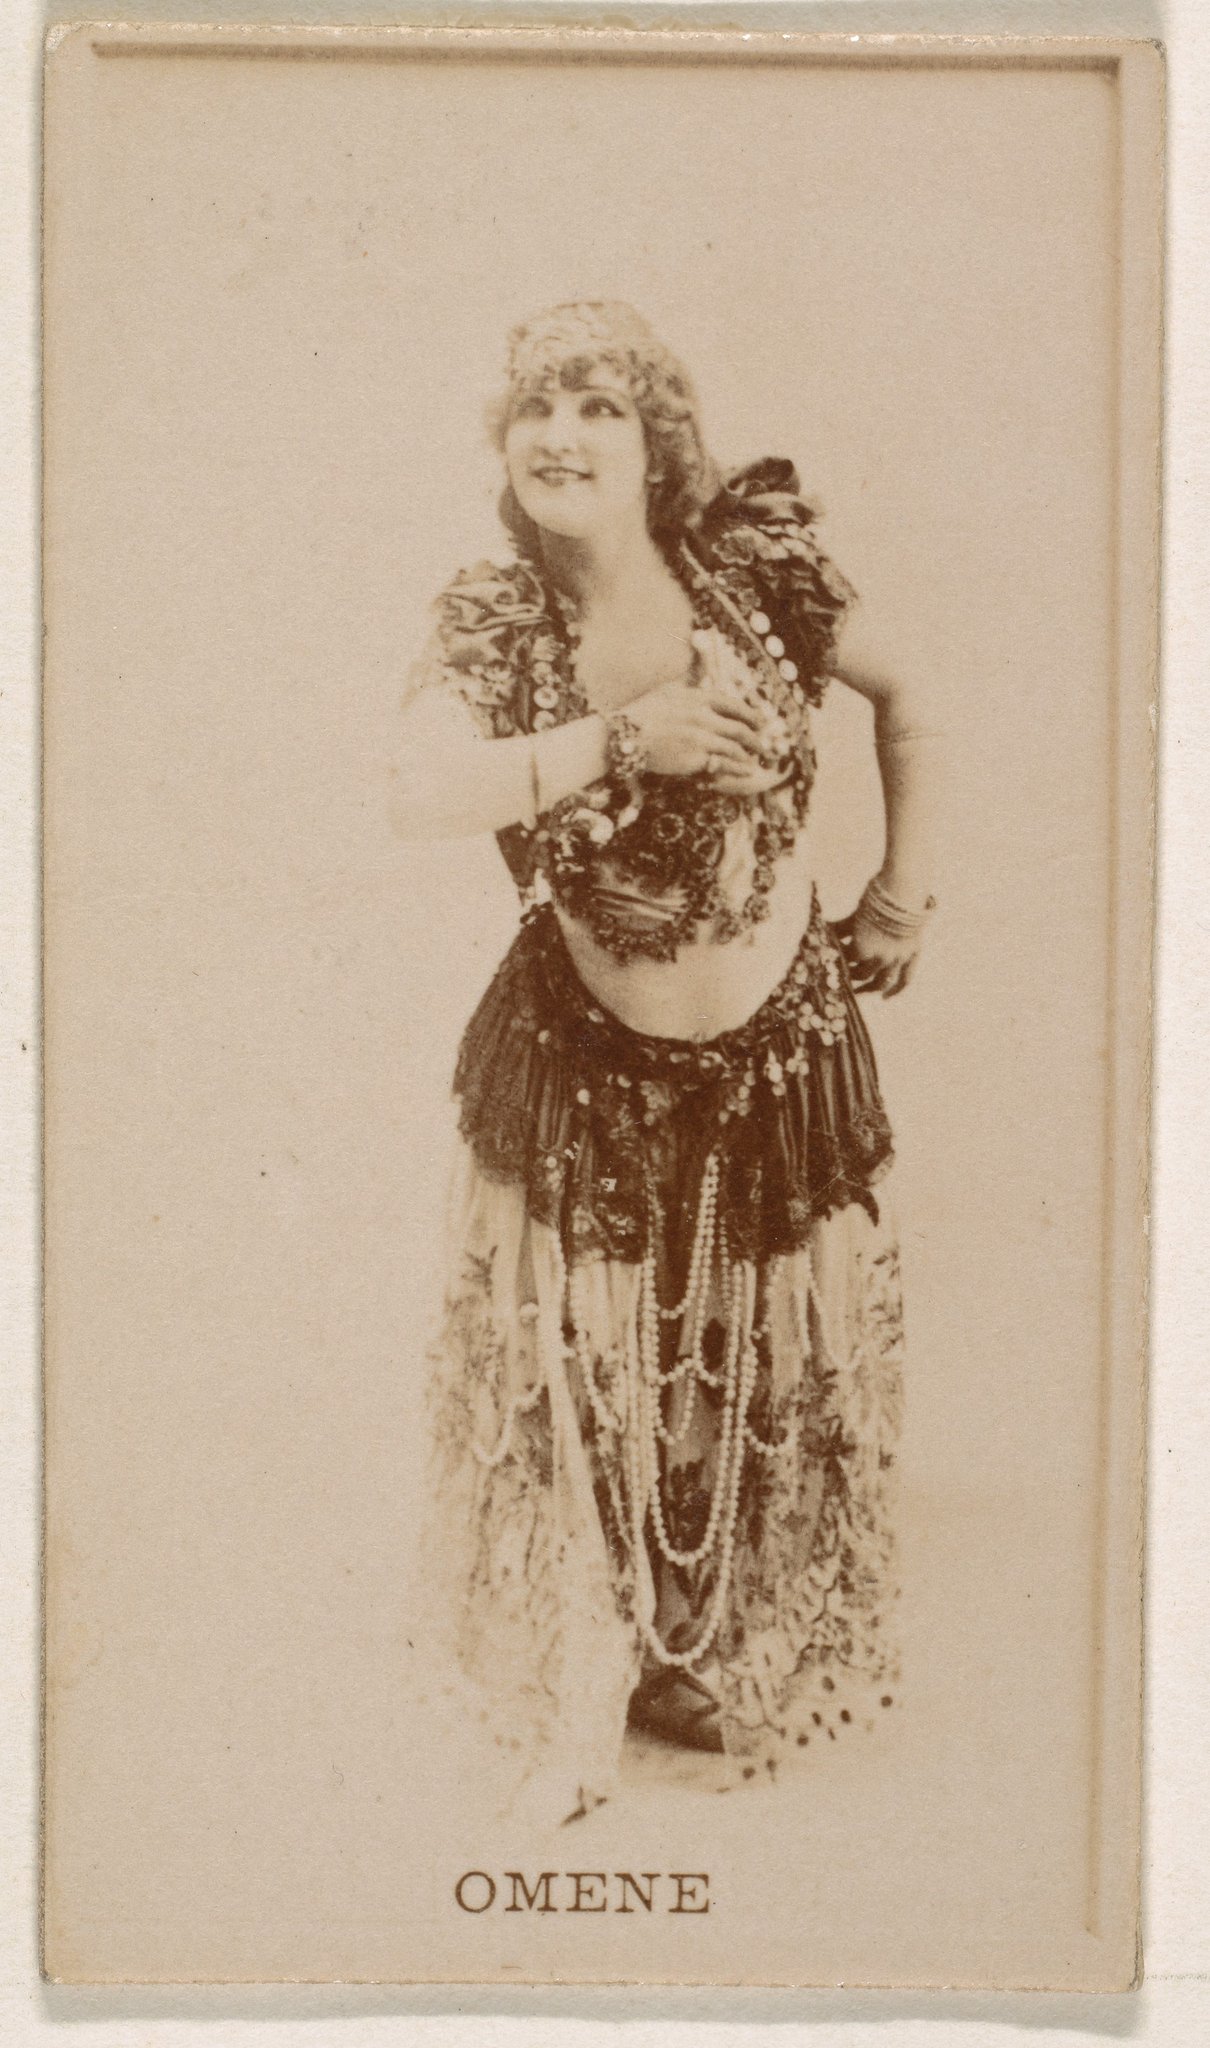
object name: photograph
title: Omene, from the Actresses series (N245) issued by Kinney Brothers to promote Sweet Caporal Cigarettes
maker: kinney brothers tobacco company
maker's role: publisher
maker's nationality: american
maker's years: 1869-2011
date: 1890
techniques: albumen silver print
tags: portraits,women,actresses